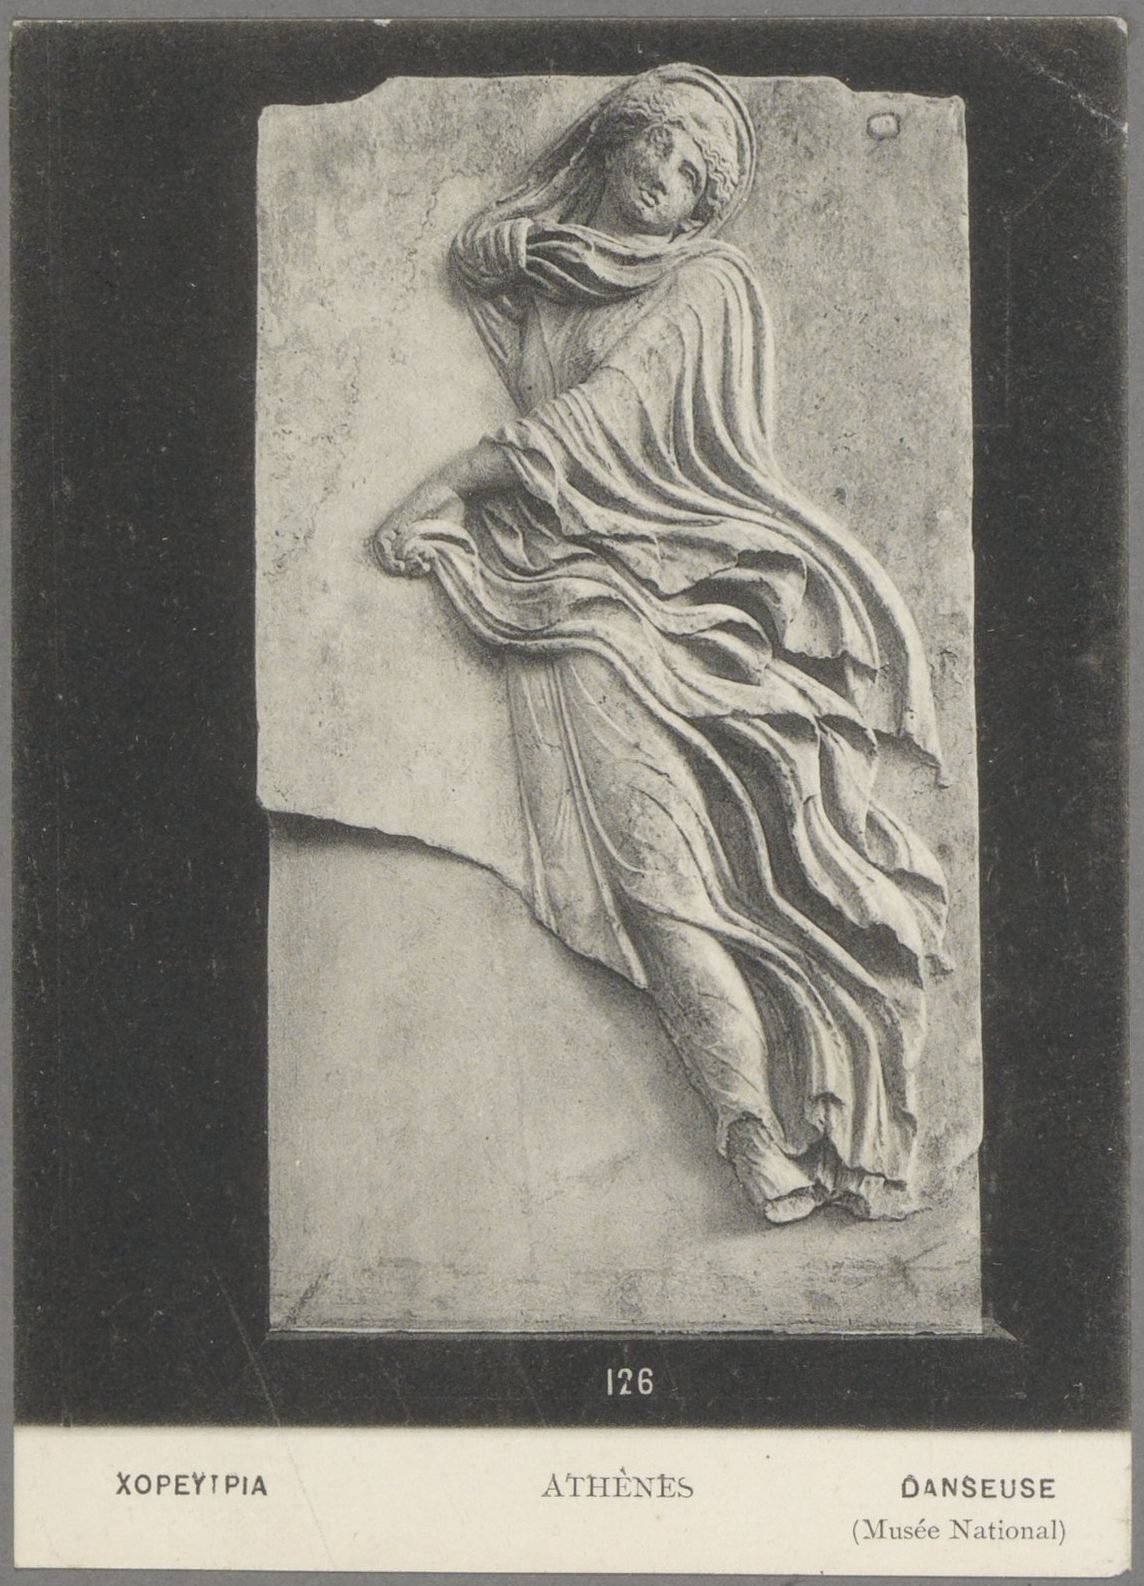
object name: album leaf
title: Beeld van een gesluierde danseres in Athene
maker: Anonymous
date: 1895-1905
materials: paper, photographic support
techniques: photograph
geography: athens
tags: portrait of dancer, sculpture (+ relief ~ sculpture)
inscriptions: number: ‘126’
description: Onderdeel van Reisalbum met foto's van bezienswaardigheden in Griekenland en Egypte.